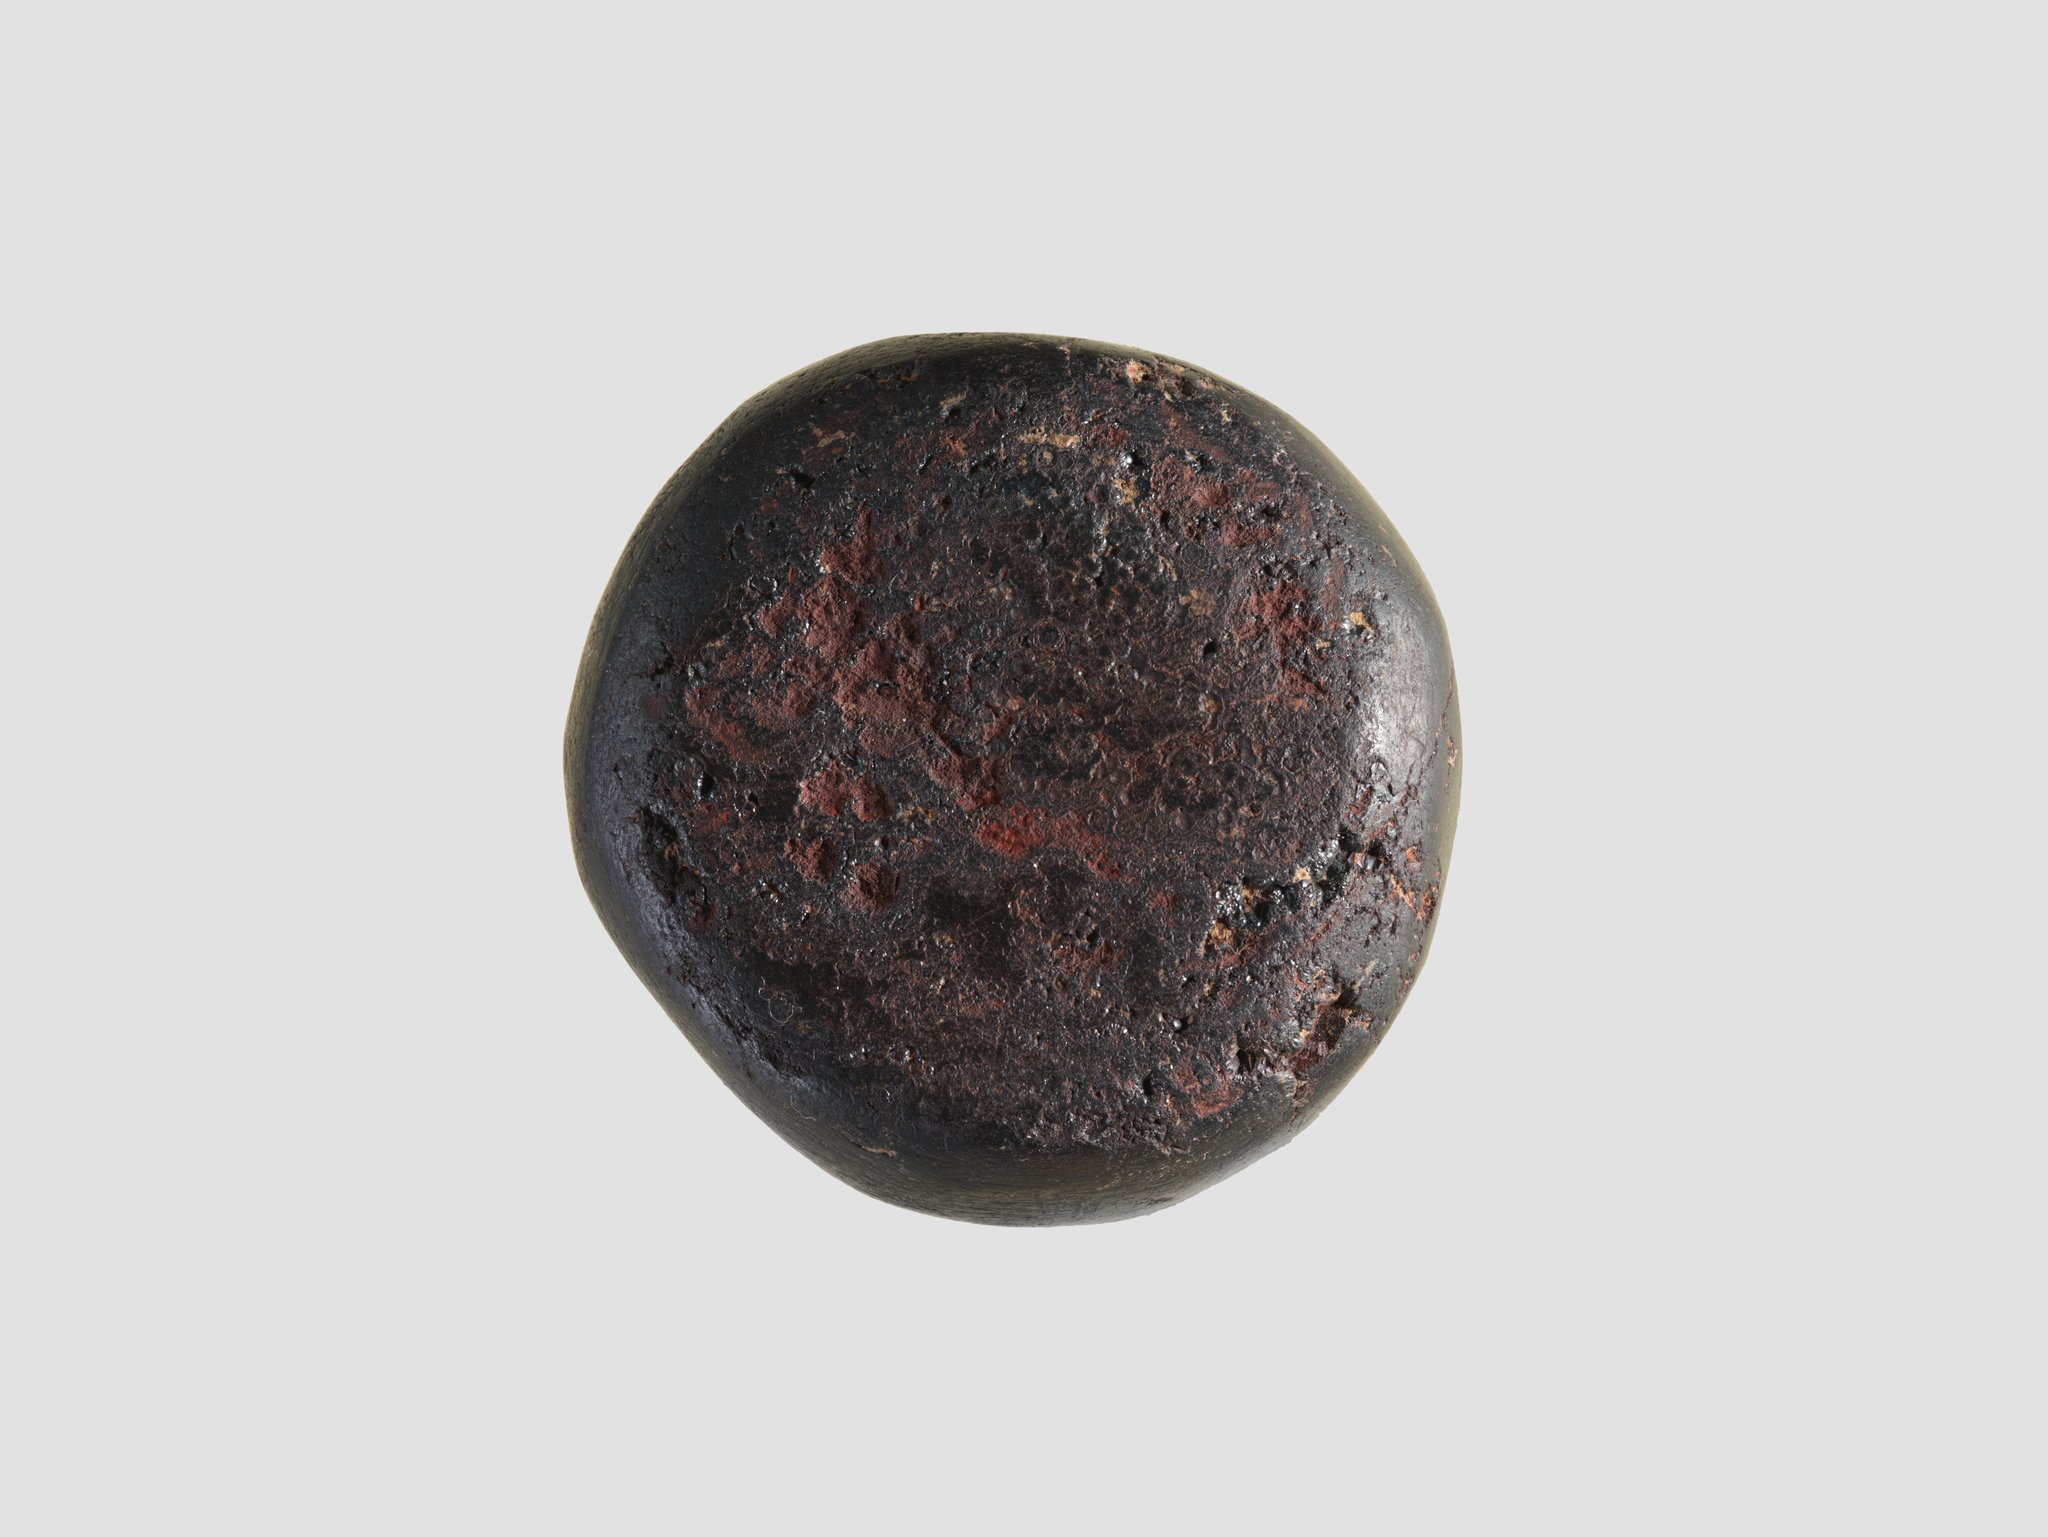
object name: weight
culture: edomite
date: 800-601 BCE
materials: mineral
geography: levant